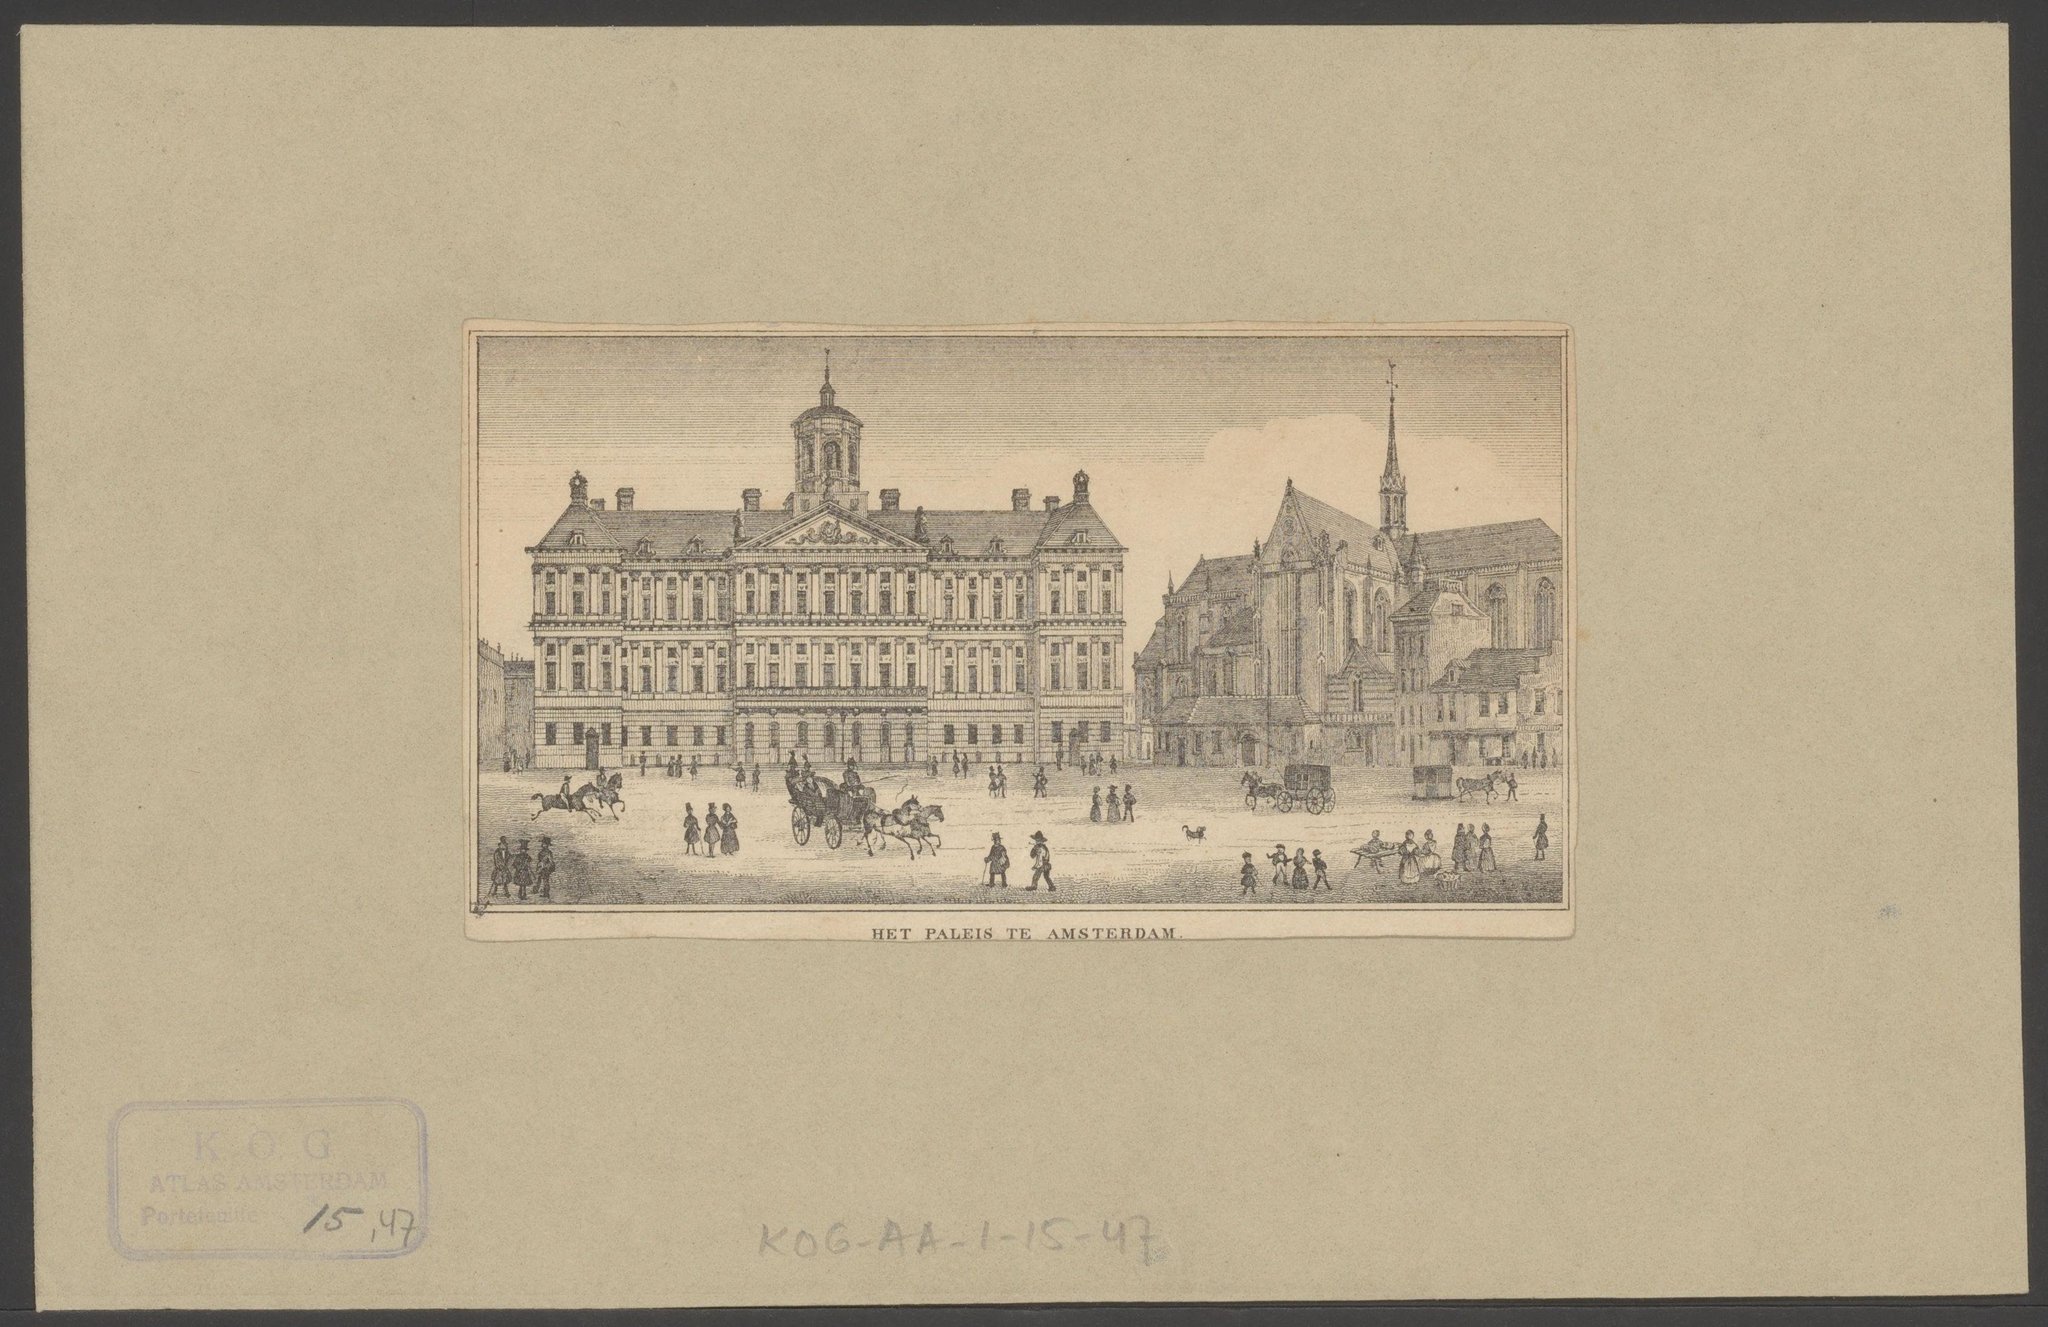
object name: print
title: Het Paleis te Amsterdam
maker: Anonymous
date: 1800-1899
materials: paper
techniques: etching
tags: square, place, circus, etc., city-view in general; 'veduta', church (exterior), townhall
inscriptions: collector's mark: ‘15,47’ Lugt 1641b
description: Onderwerpsrubriek binnen de Atlas Amsterdam: Nieuwe Stadhuis, als Paleis, op de Dam, van Buiten.